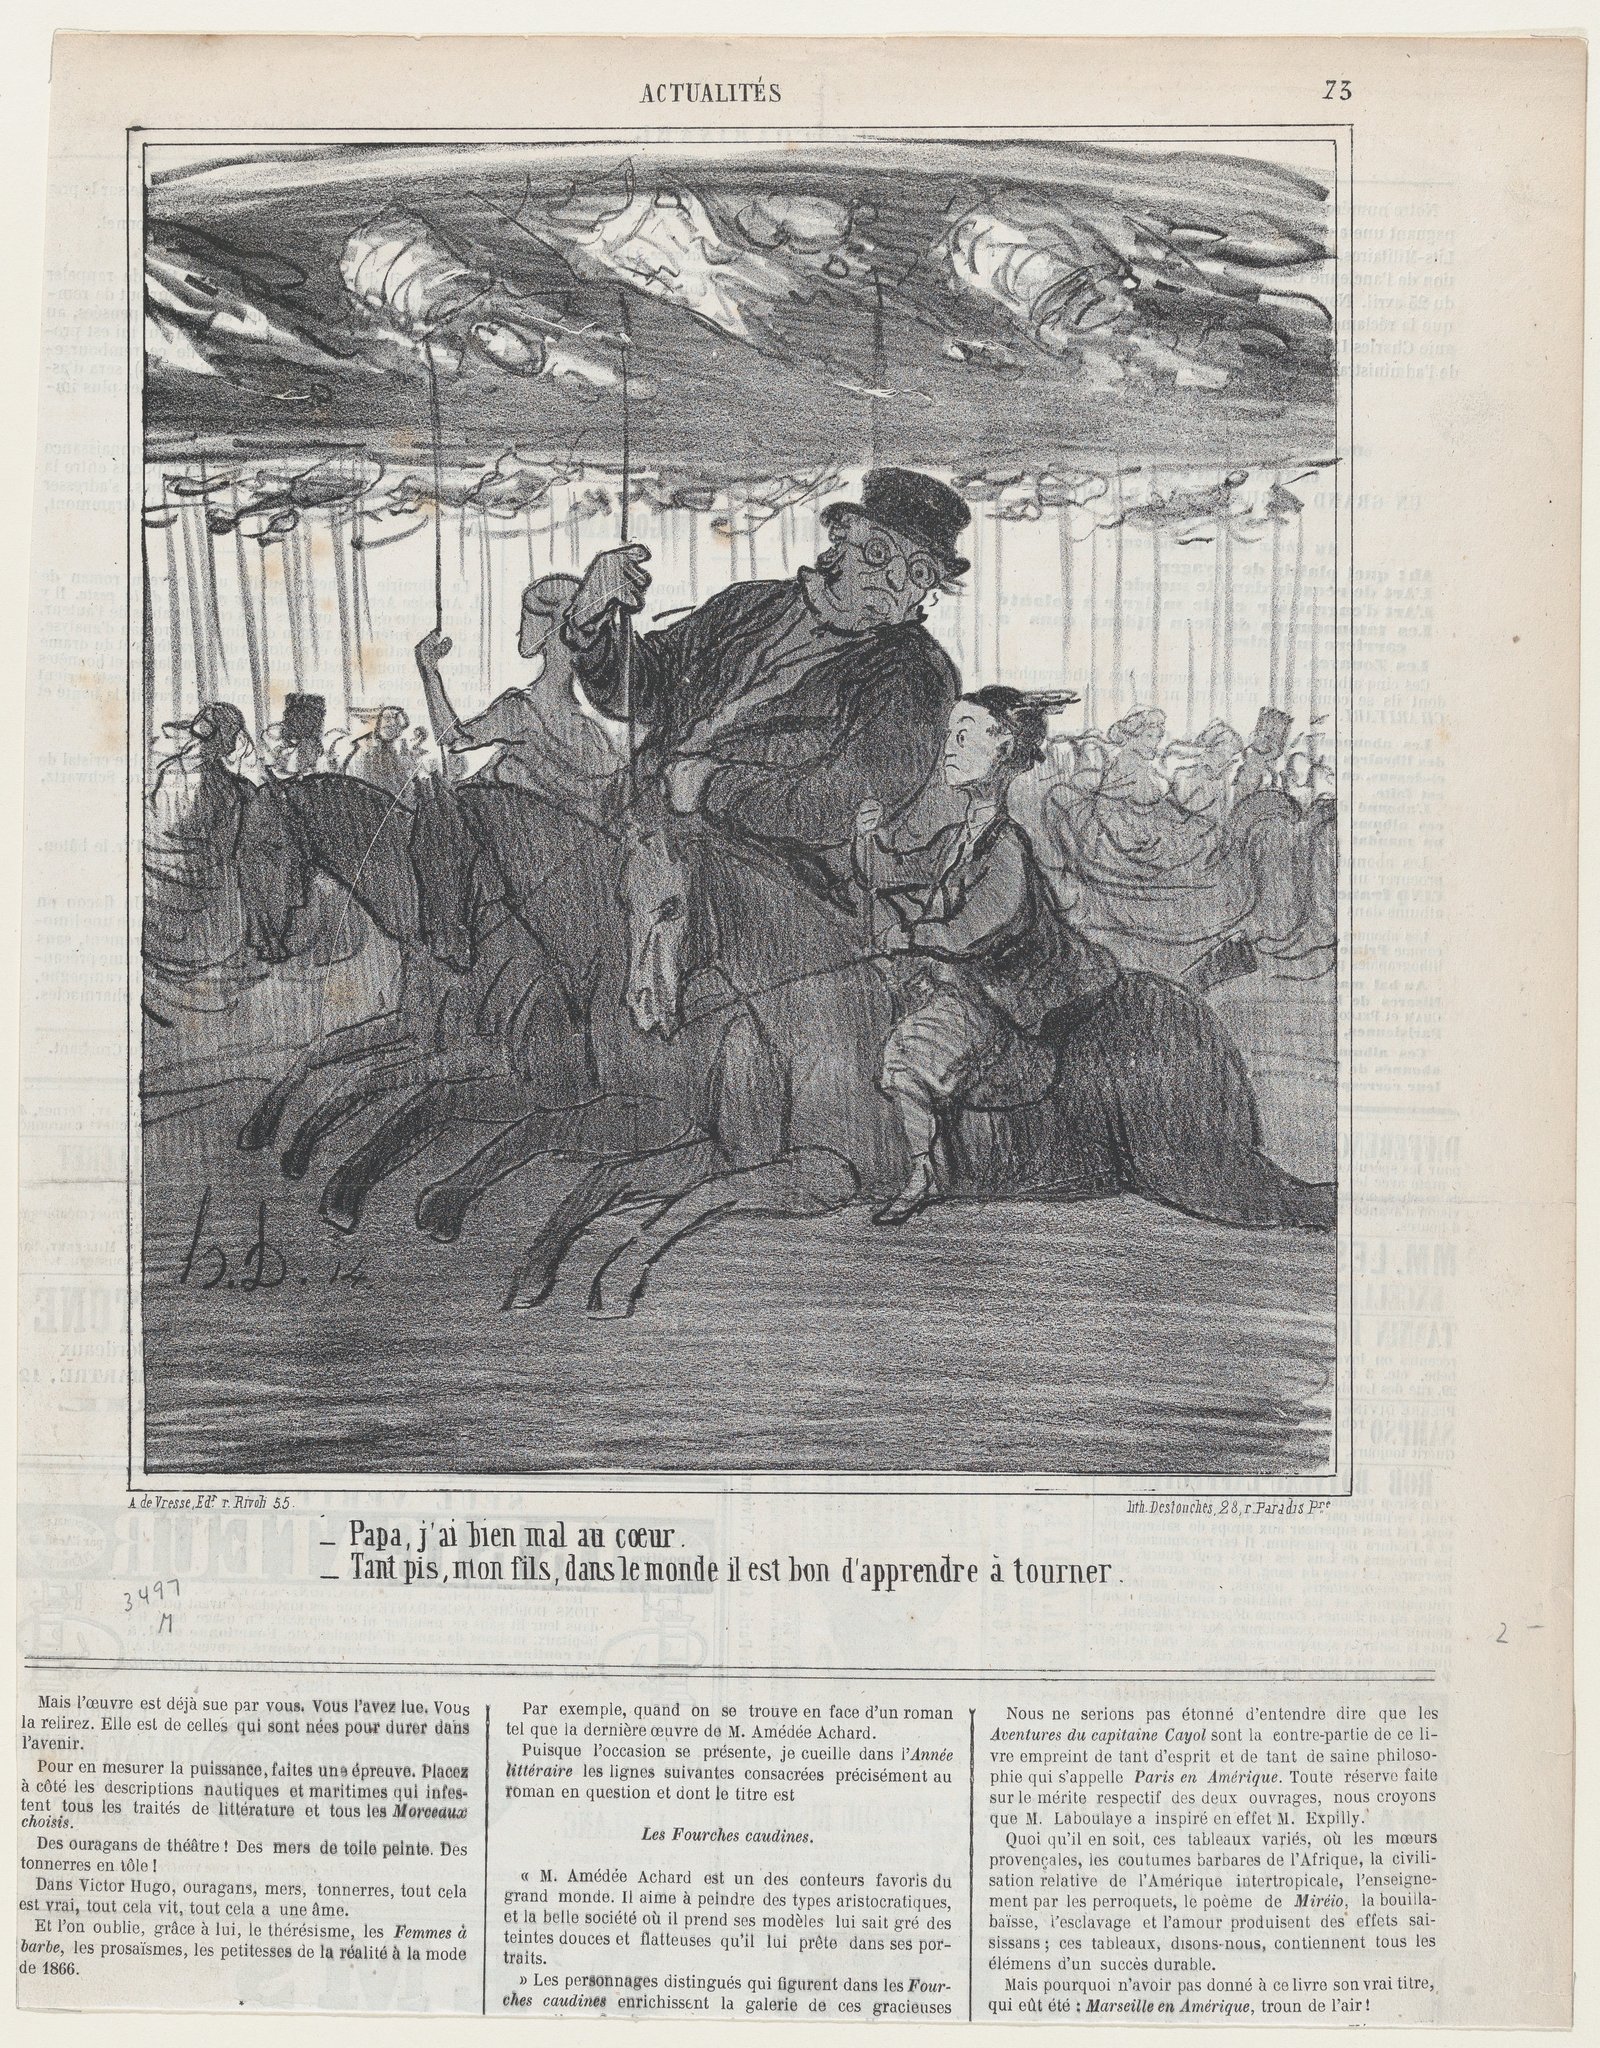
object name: print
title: –Papa, I 'm getting sick. –Too bad, my son, but in this world you must learn to go in circles, from 'News of the day,' published in Le Charivari, April 30, 1866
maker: honoré daumier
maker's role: artist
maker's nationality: french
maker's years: 1808-1879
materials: paper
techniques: lithograph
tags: boys,men,horses